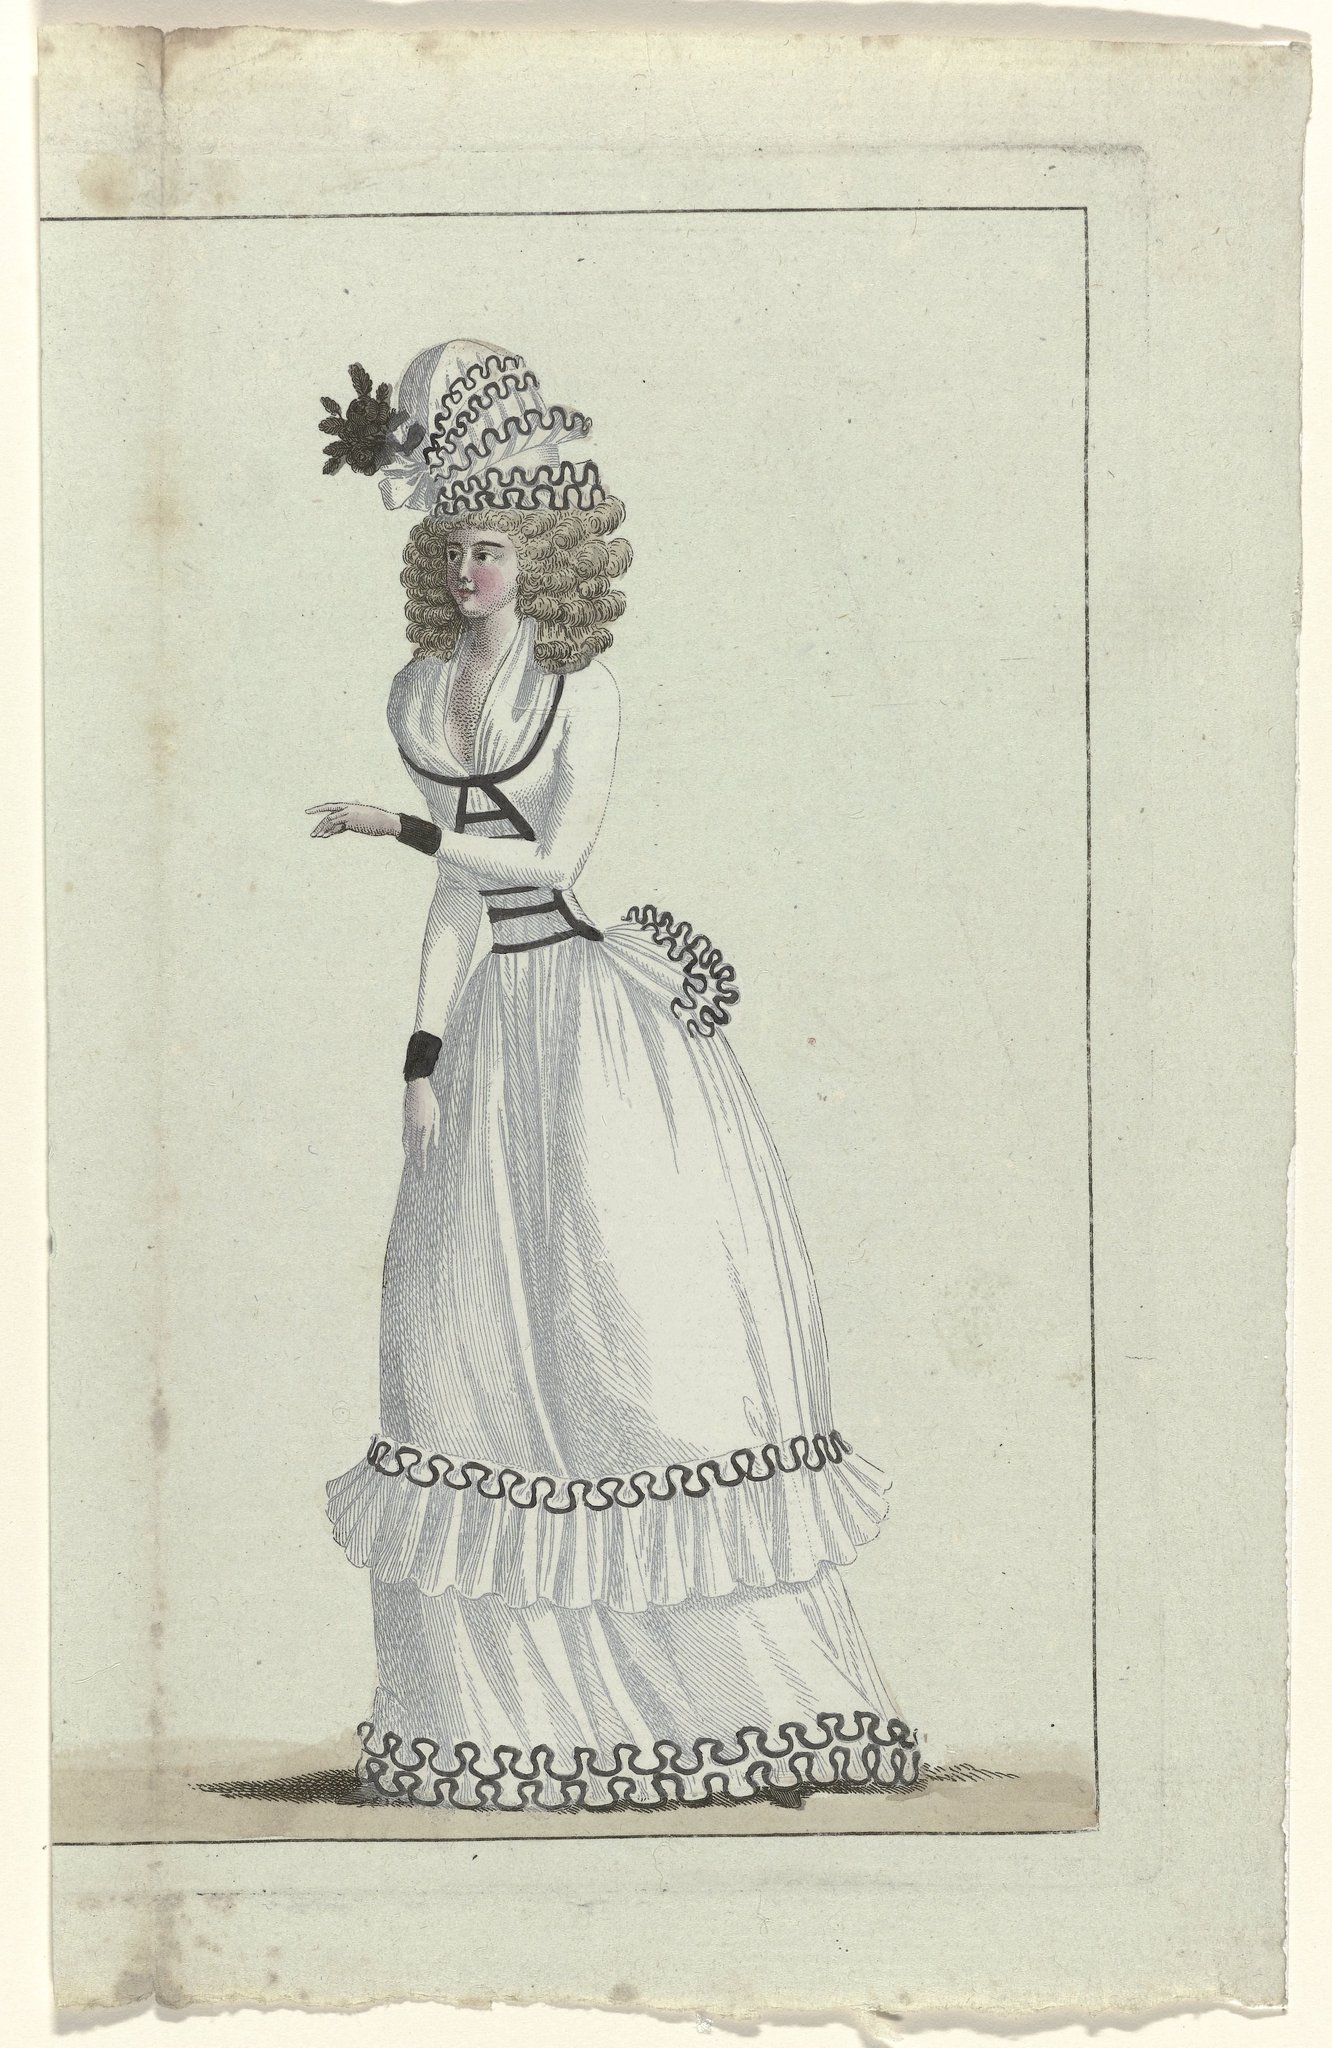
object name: fashion print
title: Fashion News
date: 1790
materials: paper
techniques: engraving, hand coloring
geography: paris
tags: clothing for the upper part of the body (caraco) (+ women's clothes), fashion plates, head-gear: hat (+ women's clothes), skirt (+ women's clothes), mourning dress, piece of clothing covering the breast or décolleté (fichu) (+ women's clothes)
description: The Cabinet des Modes offered readers highly detailed information about the illustrated clothes and accessories. It reported, for instance, on new clothing styles, such as the English ‘redingote’ 1; on accessories and embellishments, such as oversized muffs, buttons, ribbons and clasps; and finally, on the latest interior furnishings. For its male audience there was the fitted jacket 2 and the popular Androsmane, a hat with an upturned brim 3.